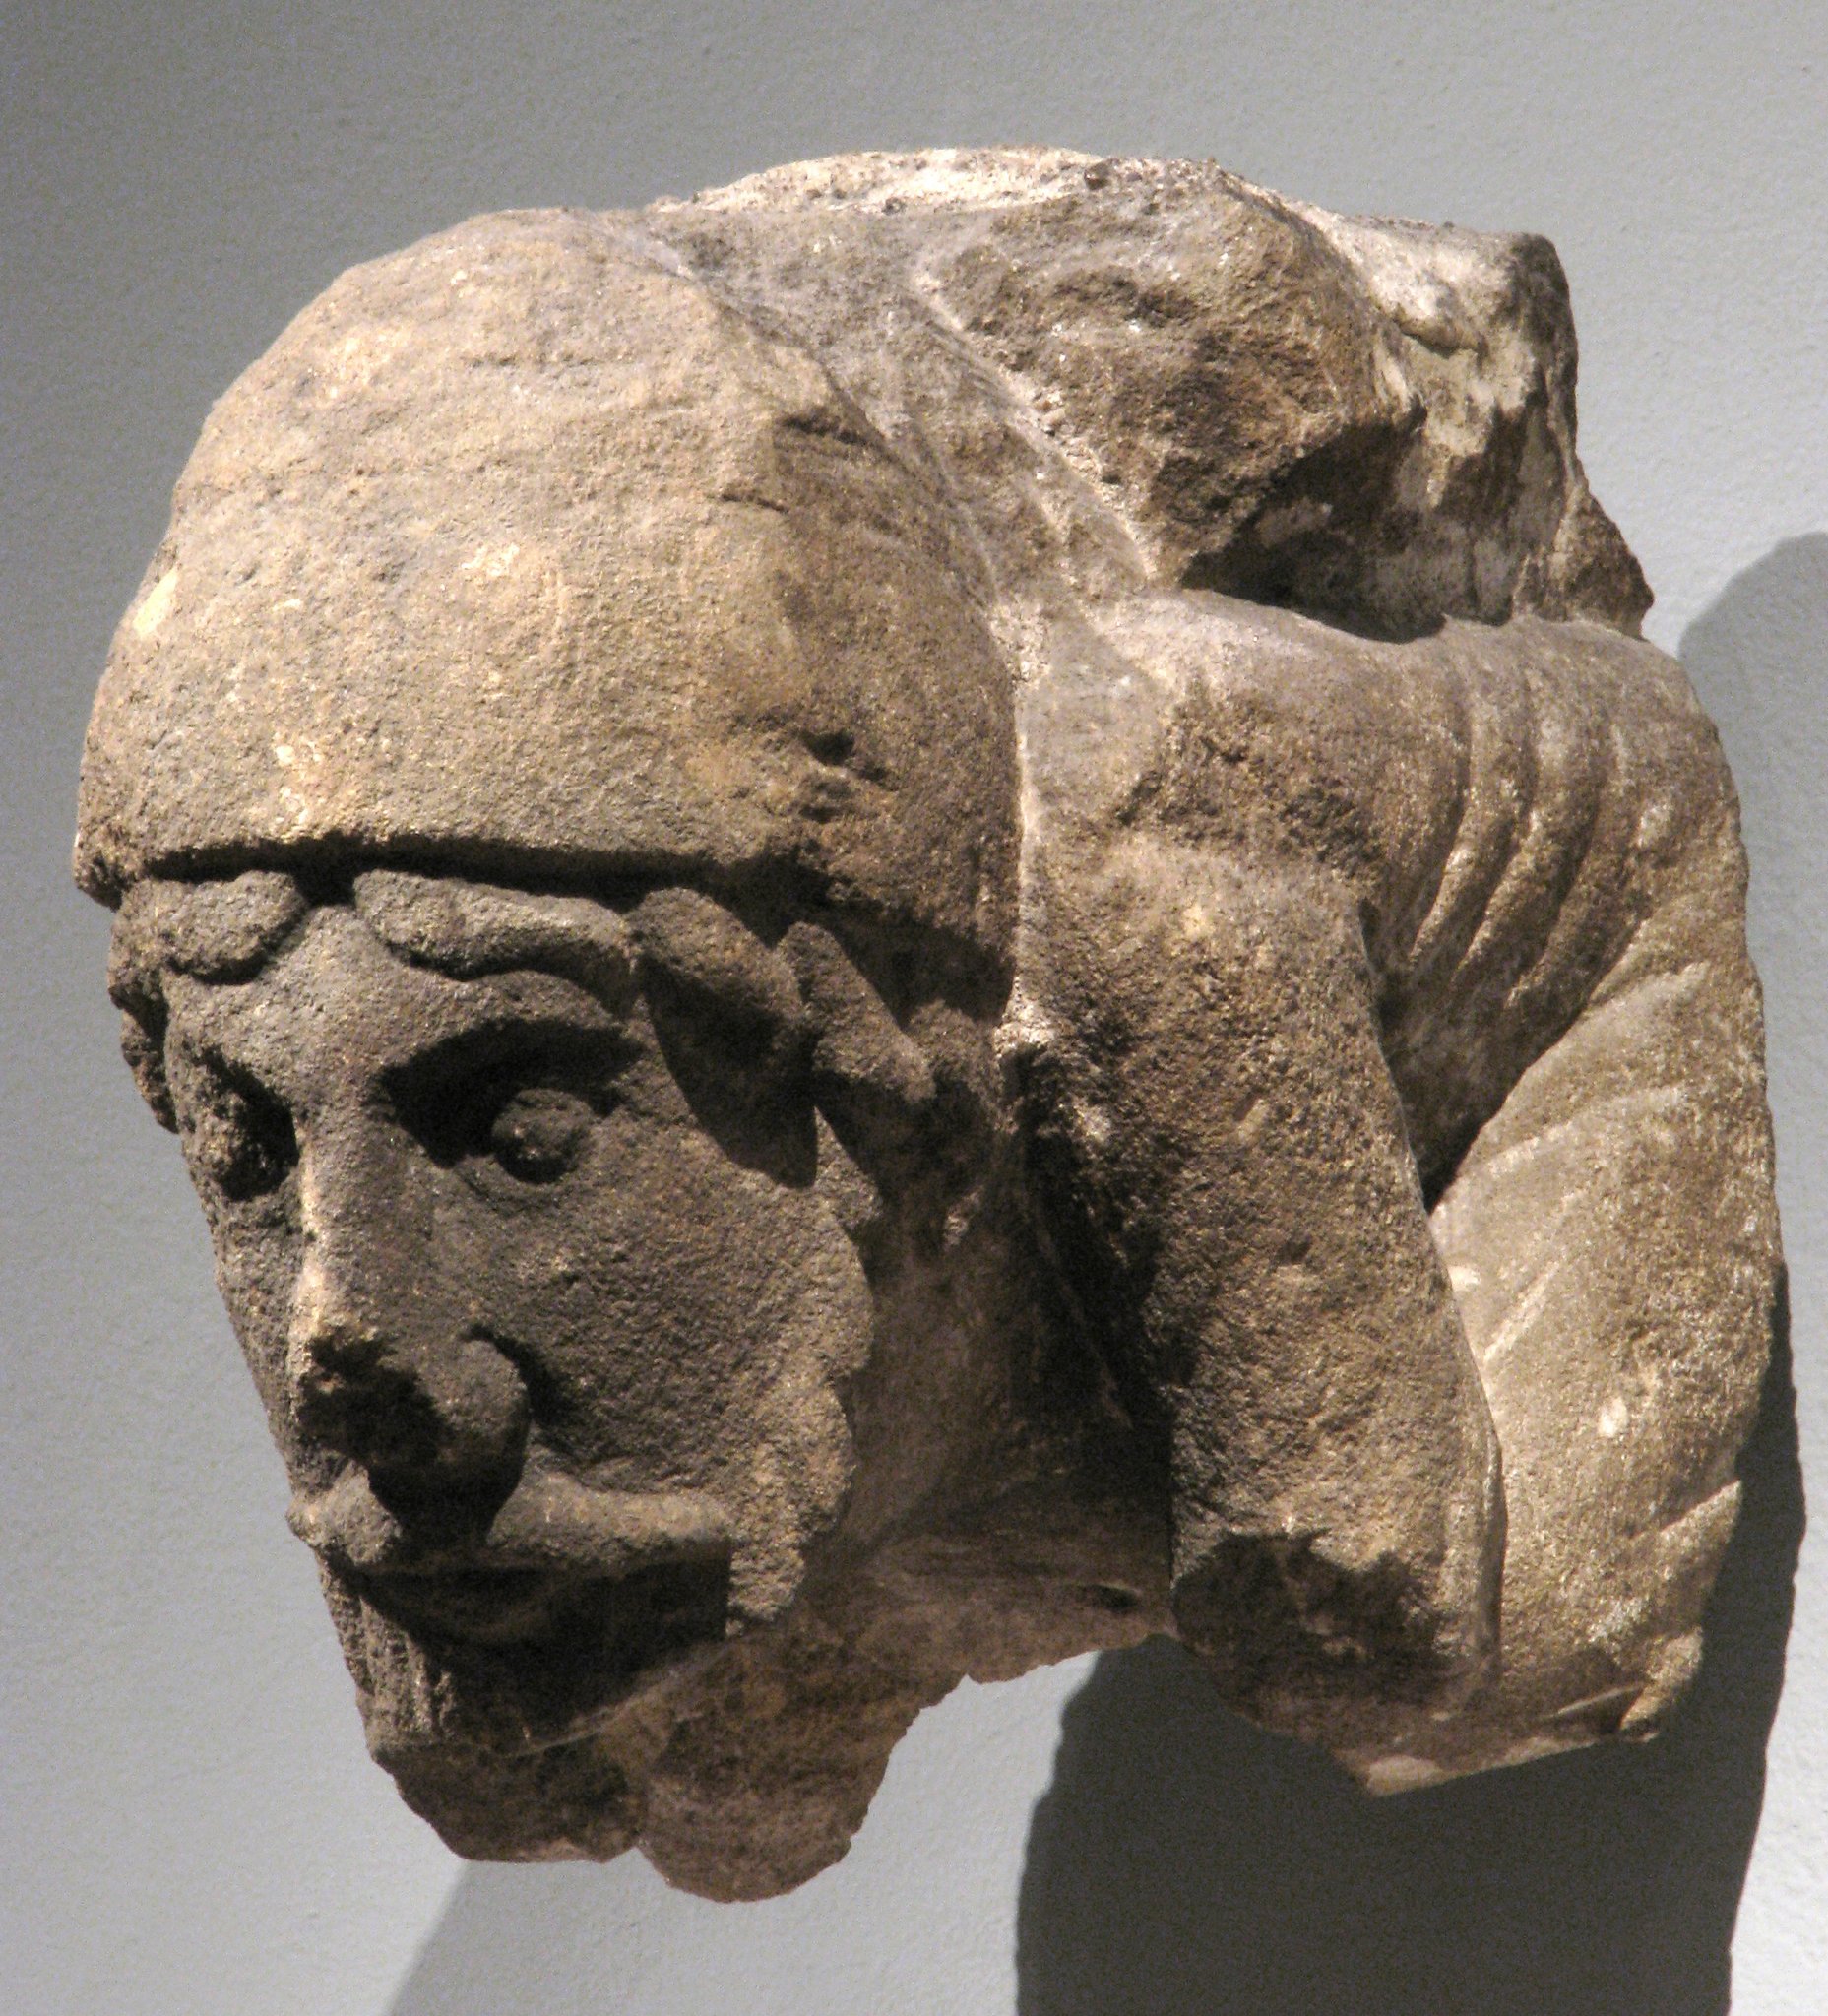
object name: corbel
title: Corbel with Crouching Male Figure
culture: central or western french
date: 1150-1175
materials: stone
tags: heads